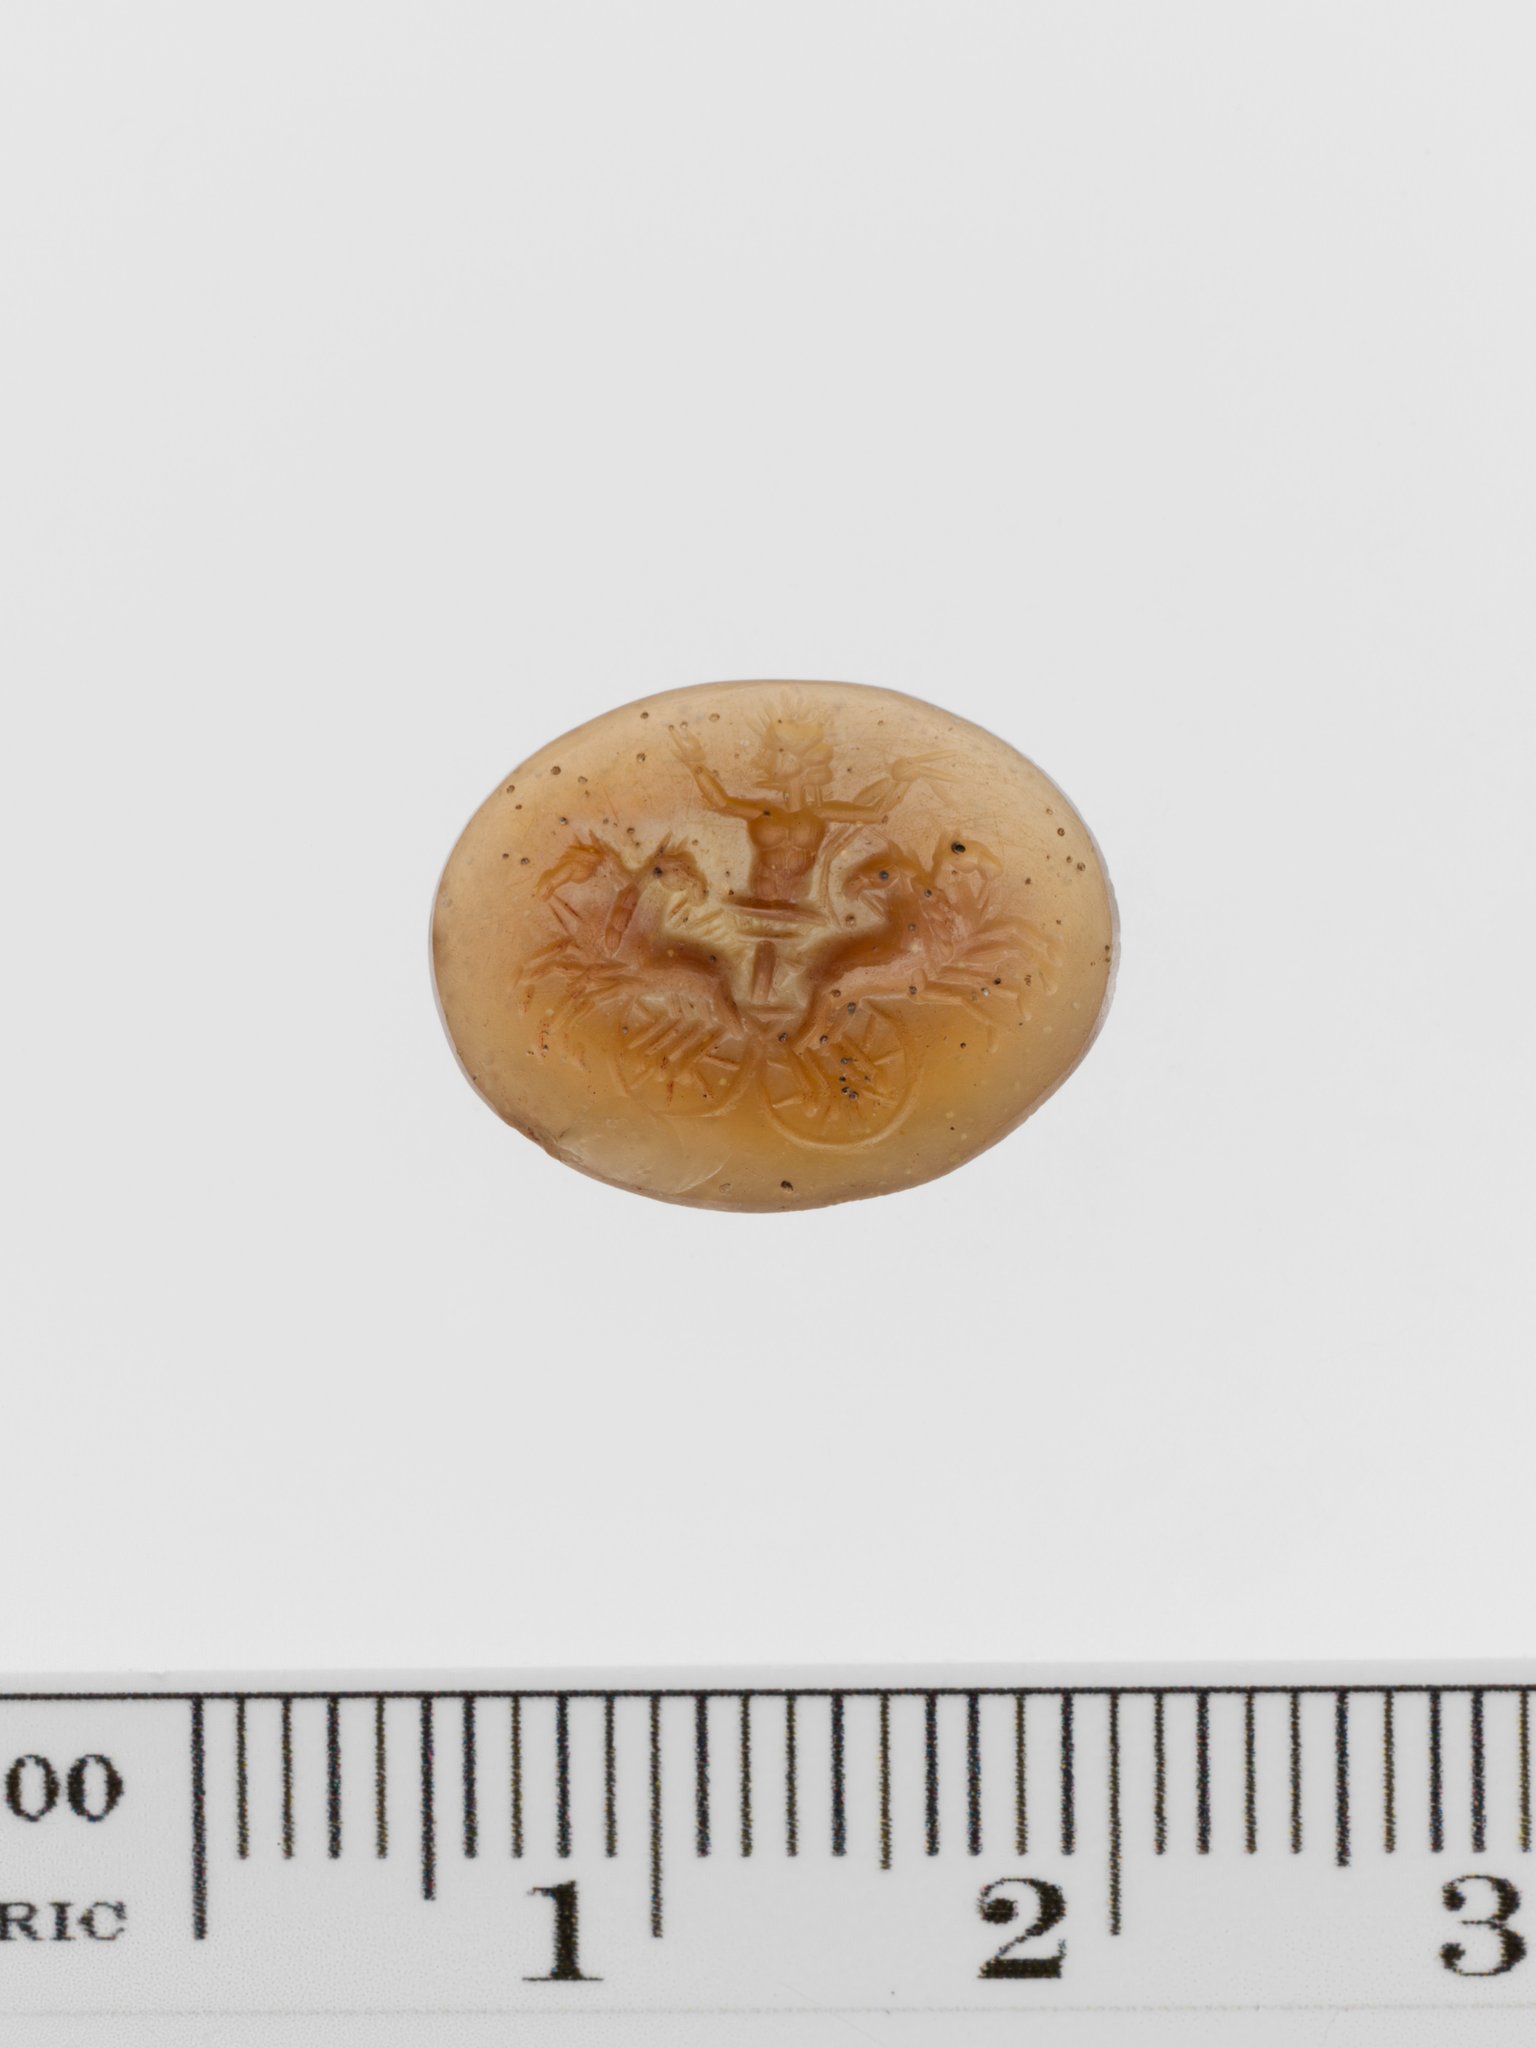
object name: intaglio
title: Yellow chalcedony ring stone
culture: roman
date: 100 BCE-300 CE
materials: stone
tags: horses,chariots